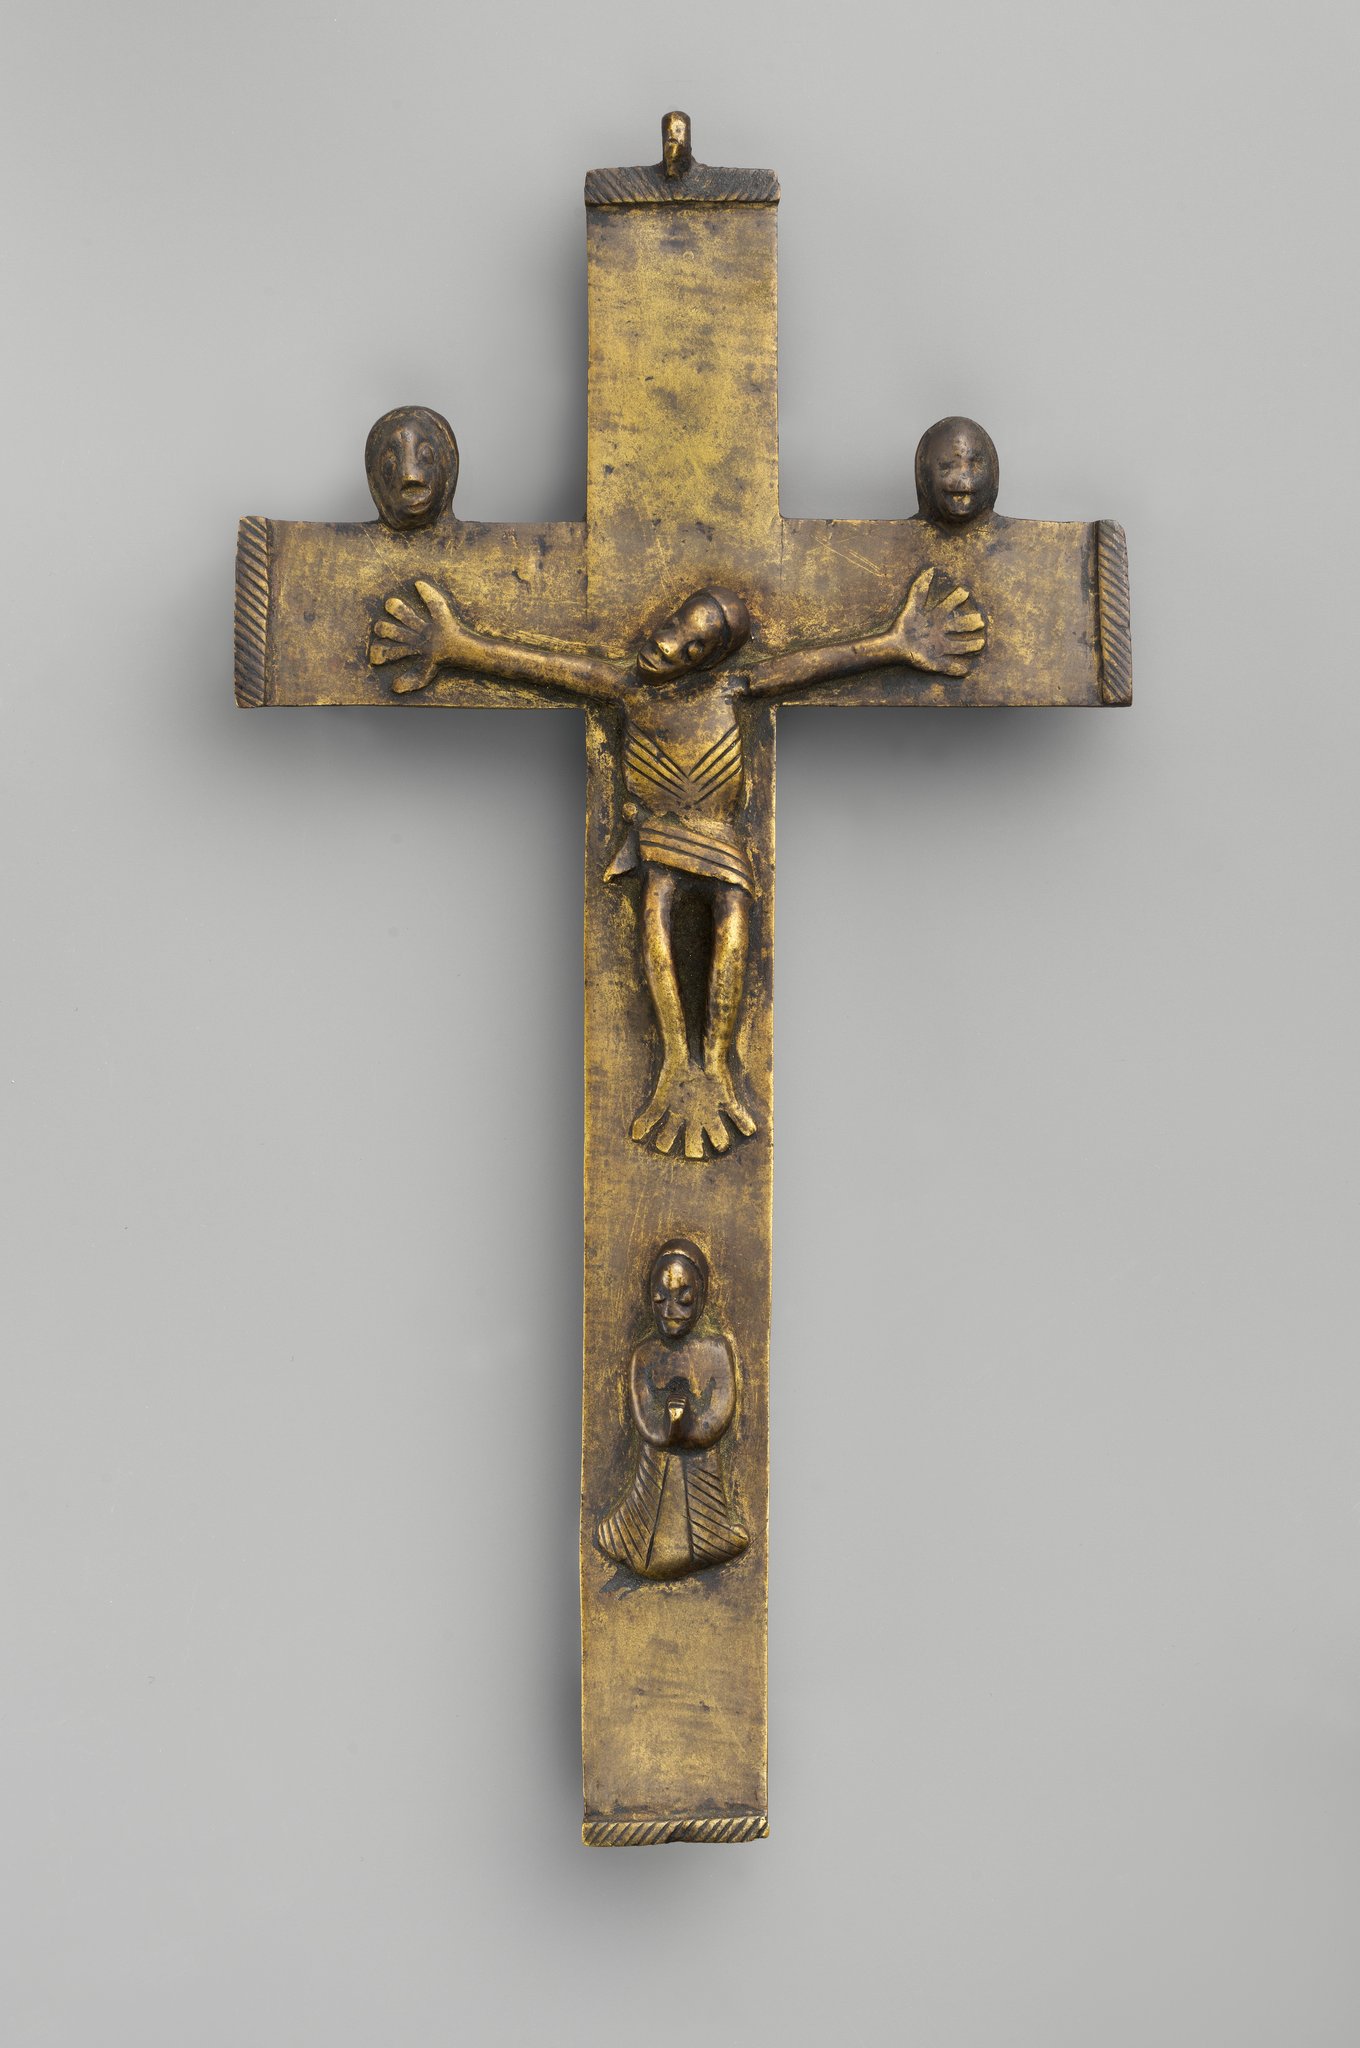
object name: crucifix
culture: kongo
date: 1601-1700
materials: brass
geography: angola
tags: christ,cross,crucifixion